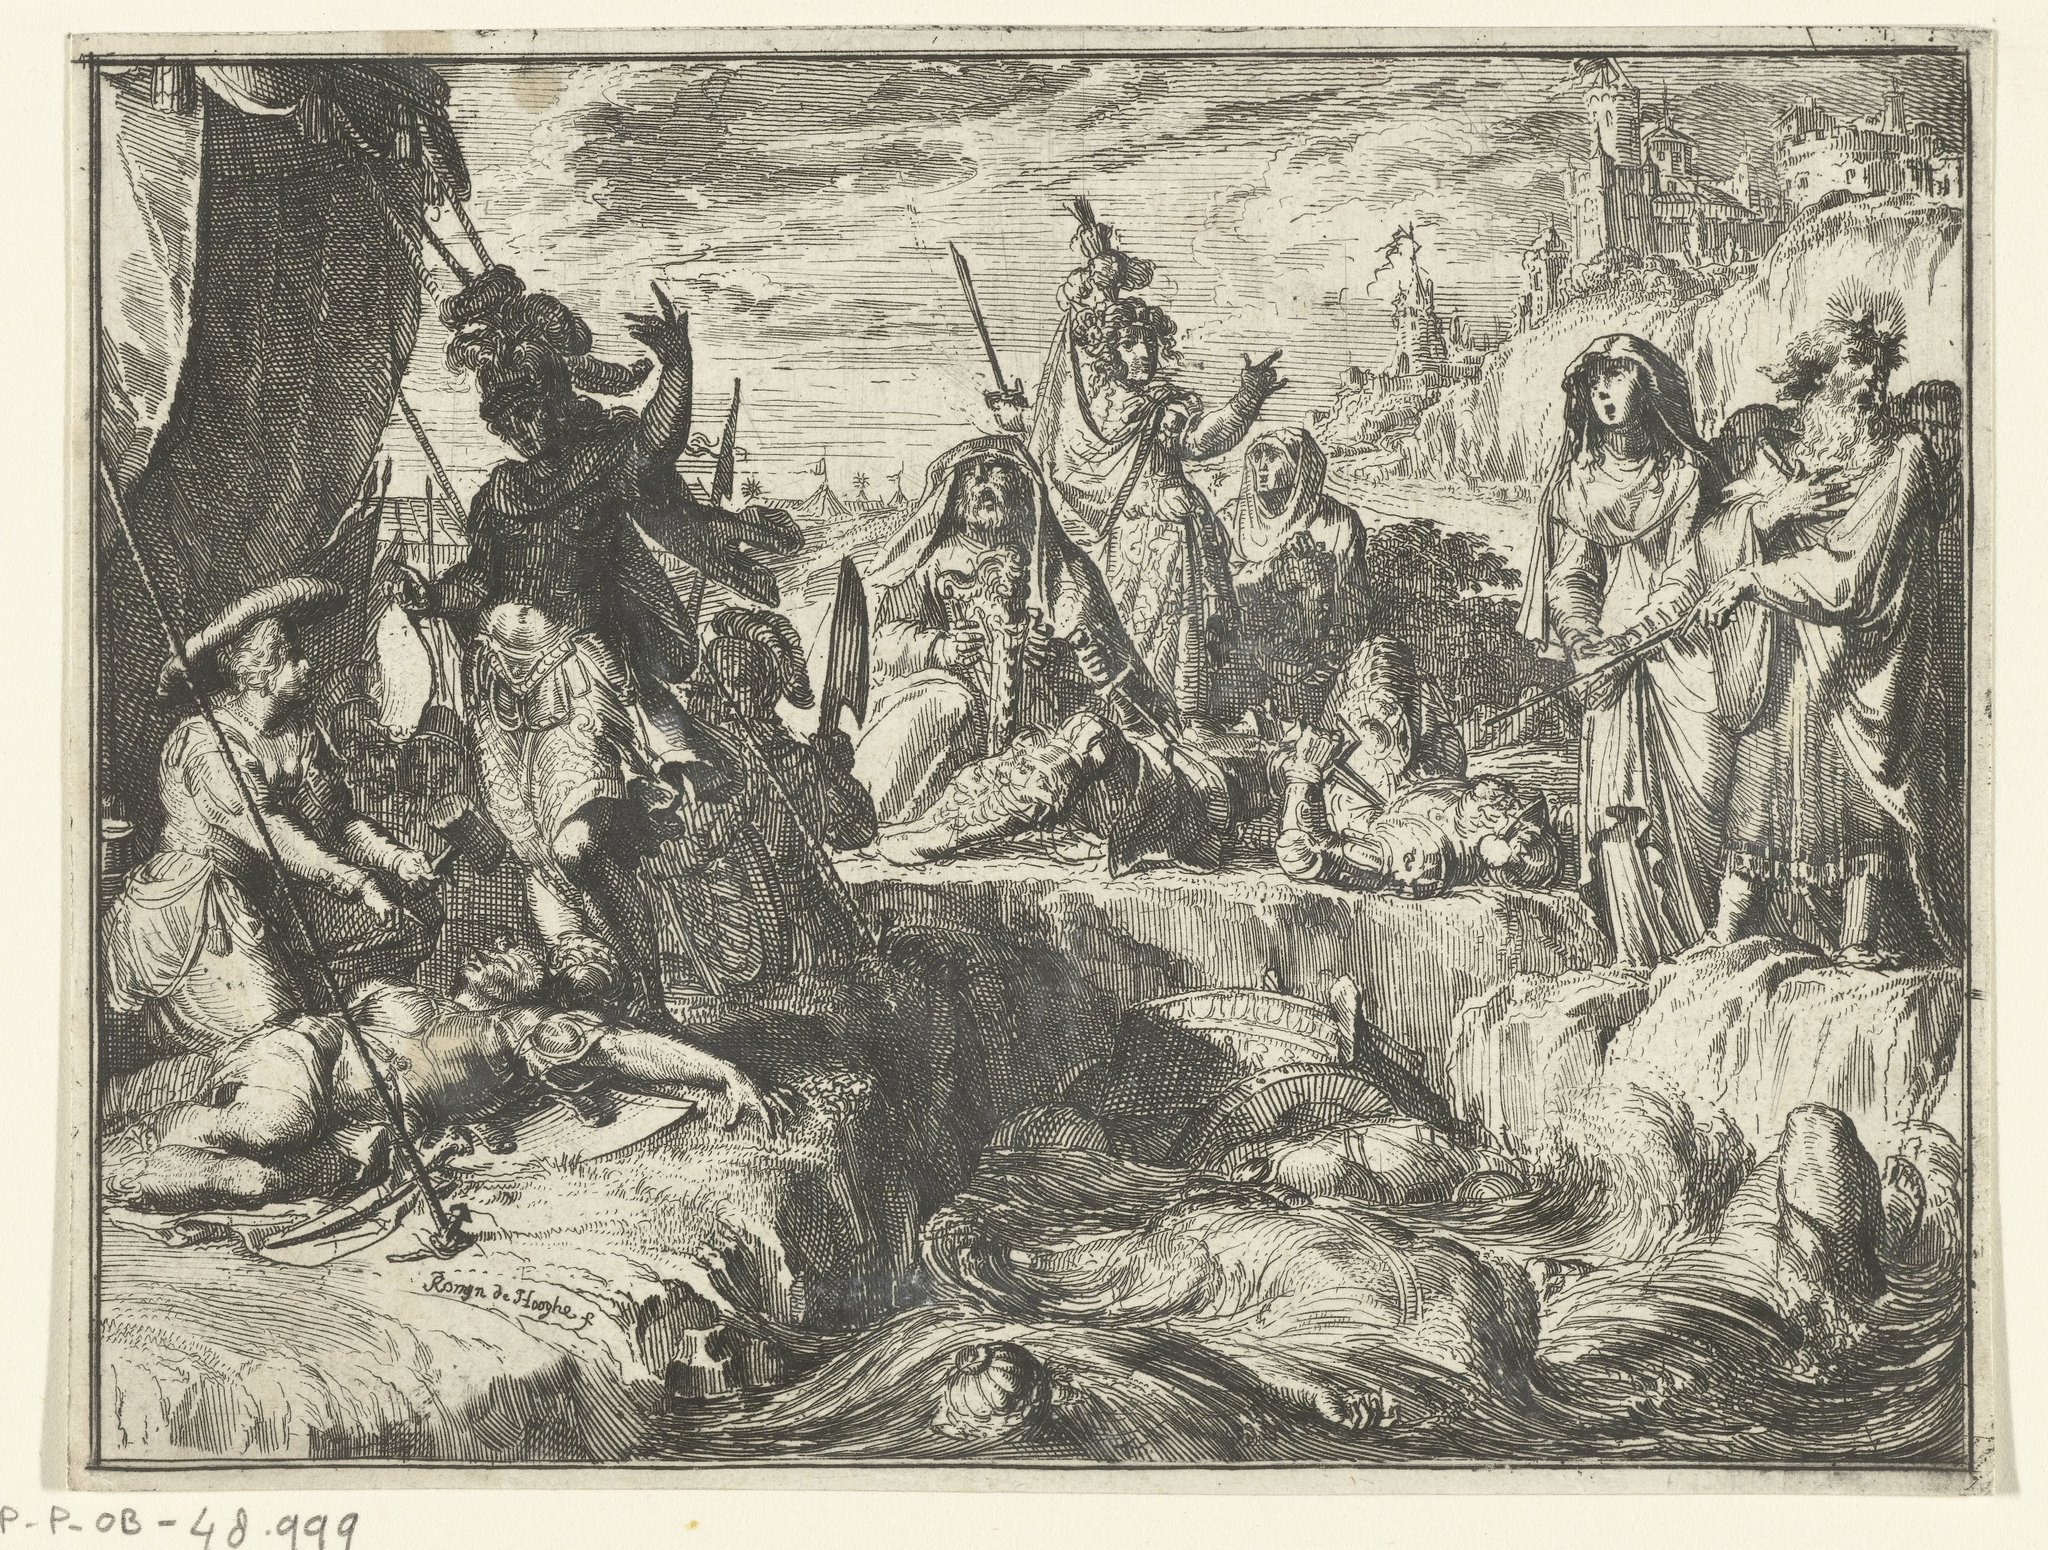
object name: print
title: De soldaten van Farao worden verzwolgen door de Rode Zee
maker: romeyn de hooghe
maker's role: draughtsman, goldsmith, painter, print maker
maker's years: 1645-1708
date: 1655-1708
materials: paper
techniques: etching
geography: netherlands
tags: with his people safe on the shore, moses raises his hands and causes the water to return; pharaoh's army perishes in the water (red sea)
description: De soldaten van Farao worden verzwolgen door de Rode Zee. Rechts aan de oever staat Mozes met staf.